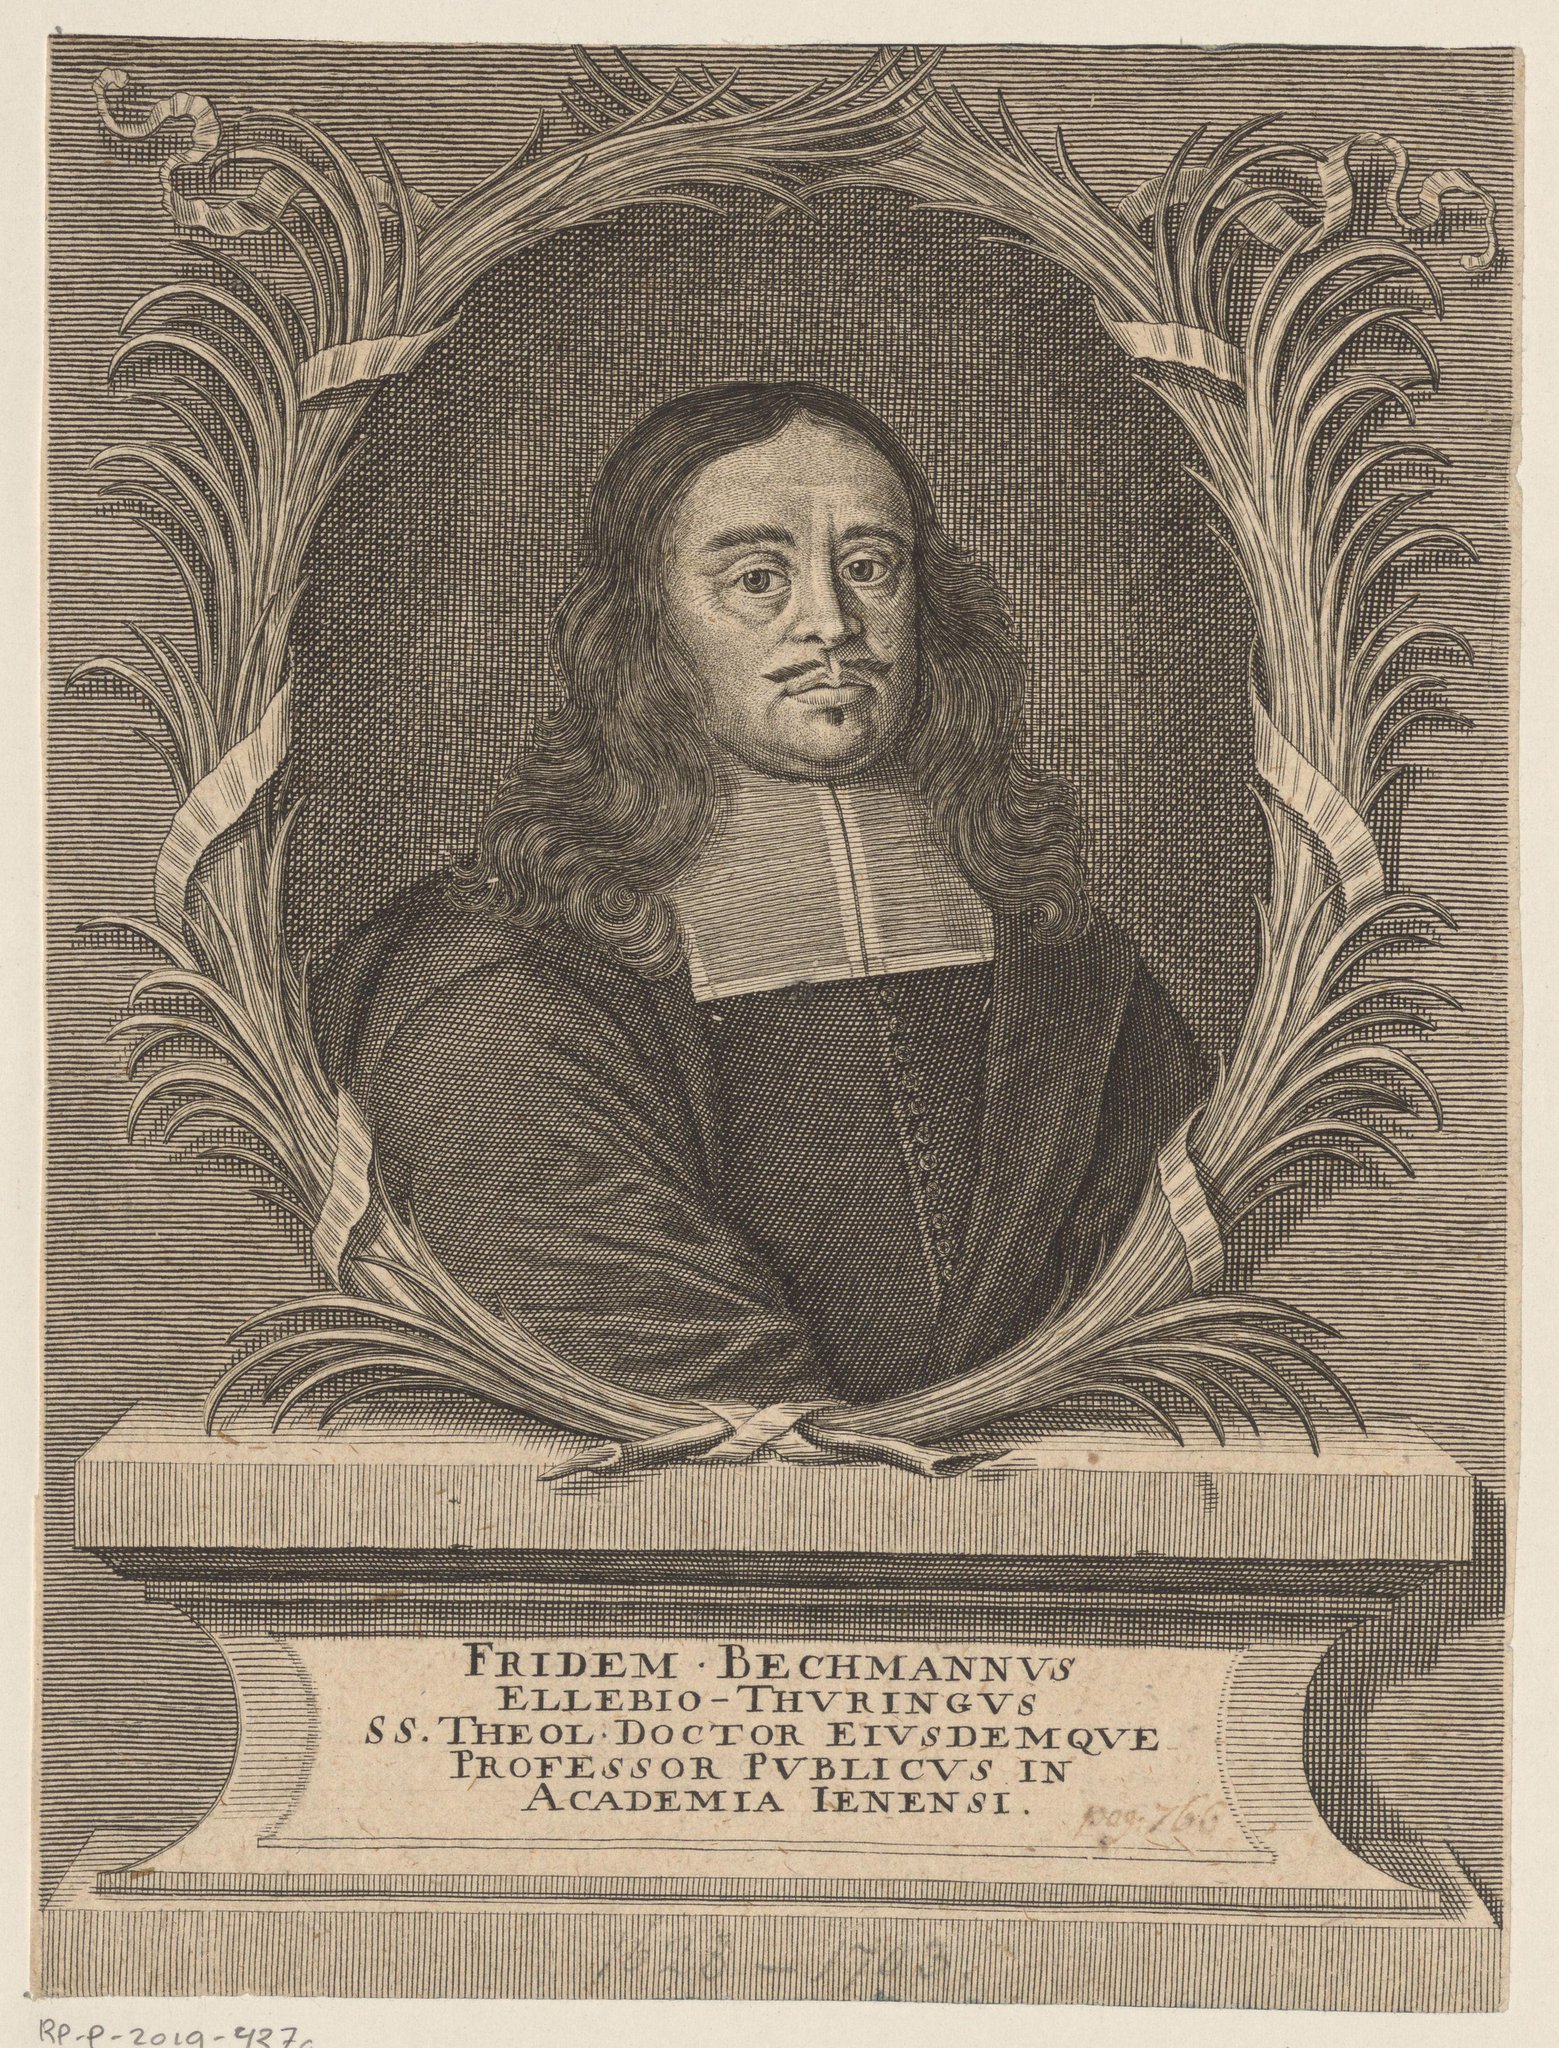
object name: print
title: Portret van Friedemann Bechmann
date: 1691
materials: paper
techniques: engraving, etching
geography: eisenach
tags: theologian, historical persons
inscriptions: inscription: ‘[...]’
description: Prent uit: Bechmann, Friedemann. Annotationes uberiores in compendium theologicum Leonhardi Hutteri (...). Eisenach: Johann Kaspar Bachmann, 1691. Prent ook gebruikt in latere edities van dit werk.